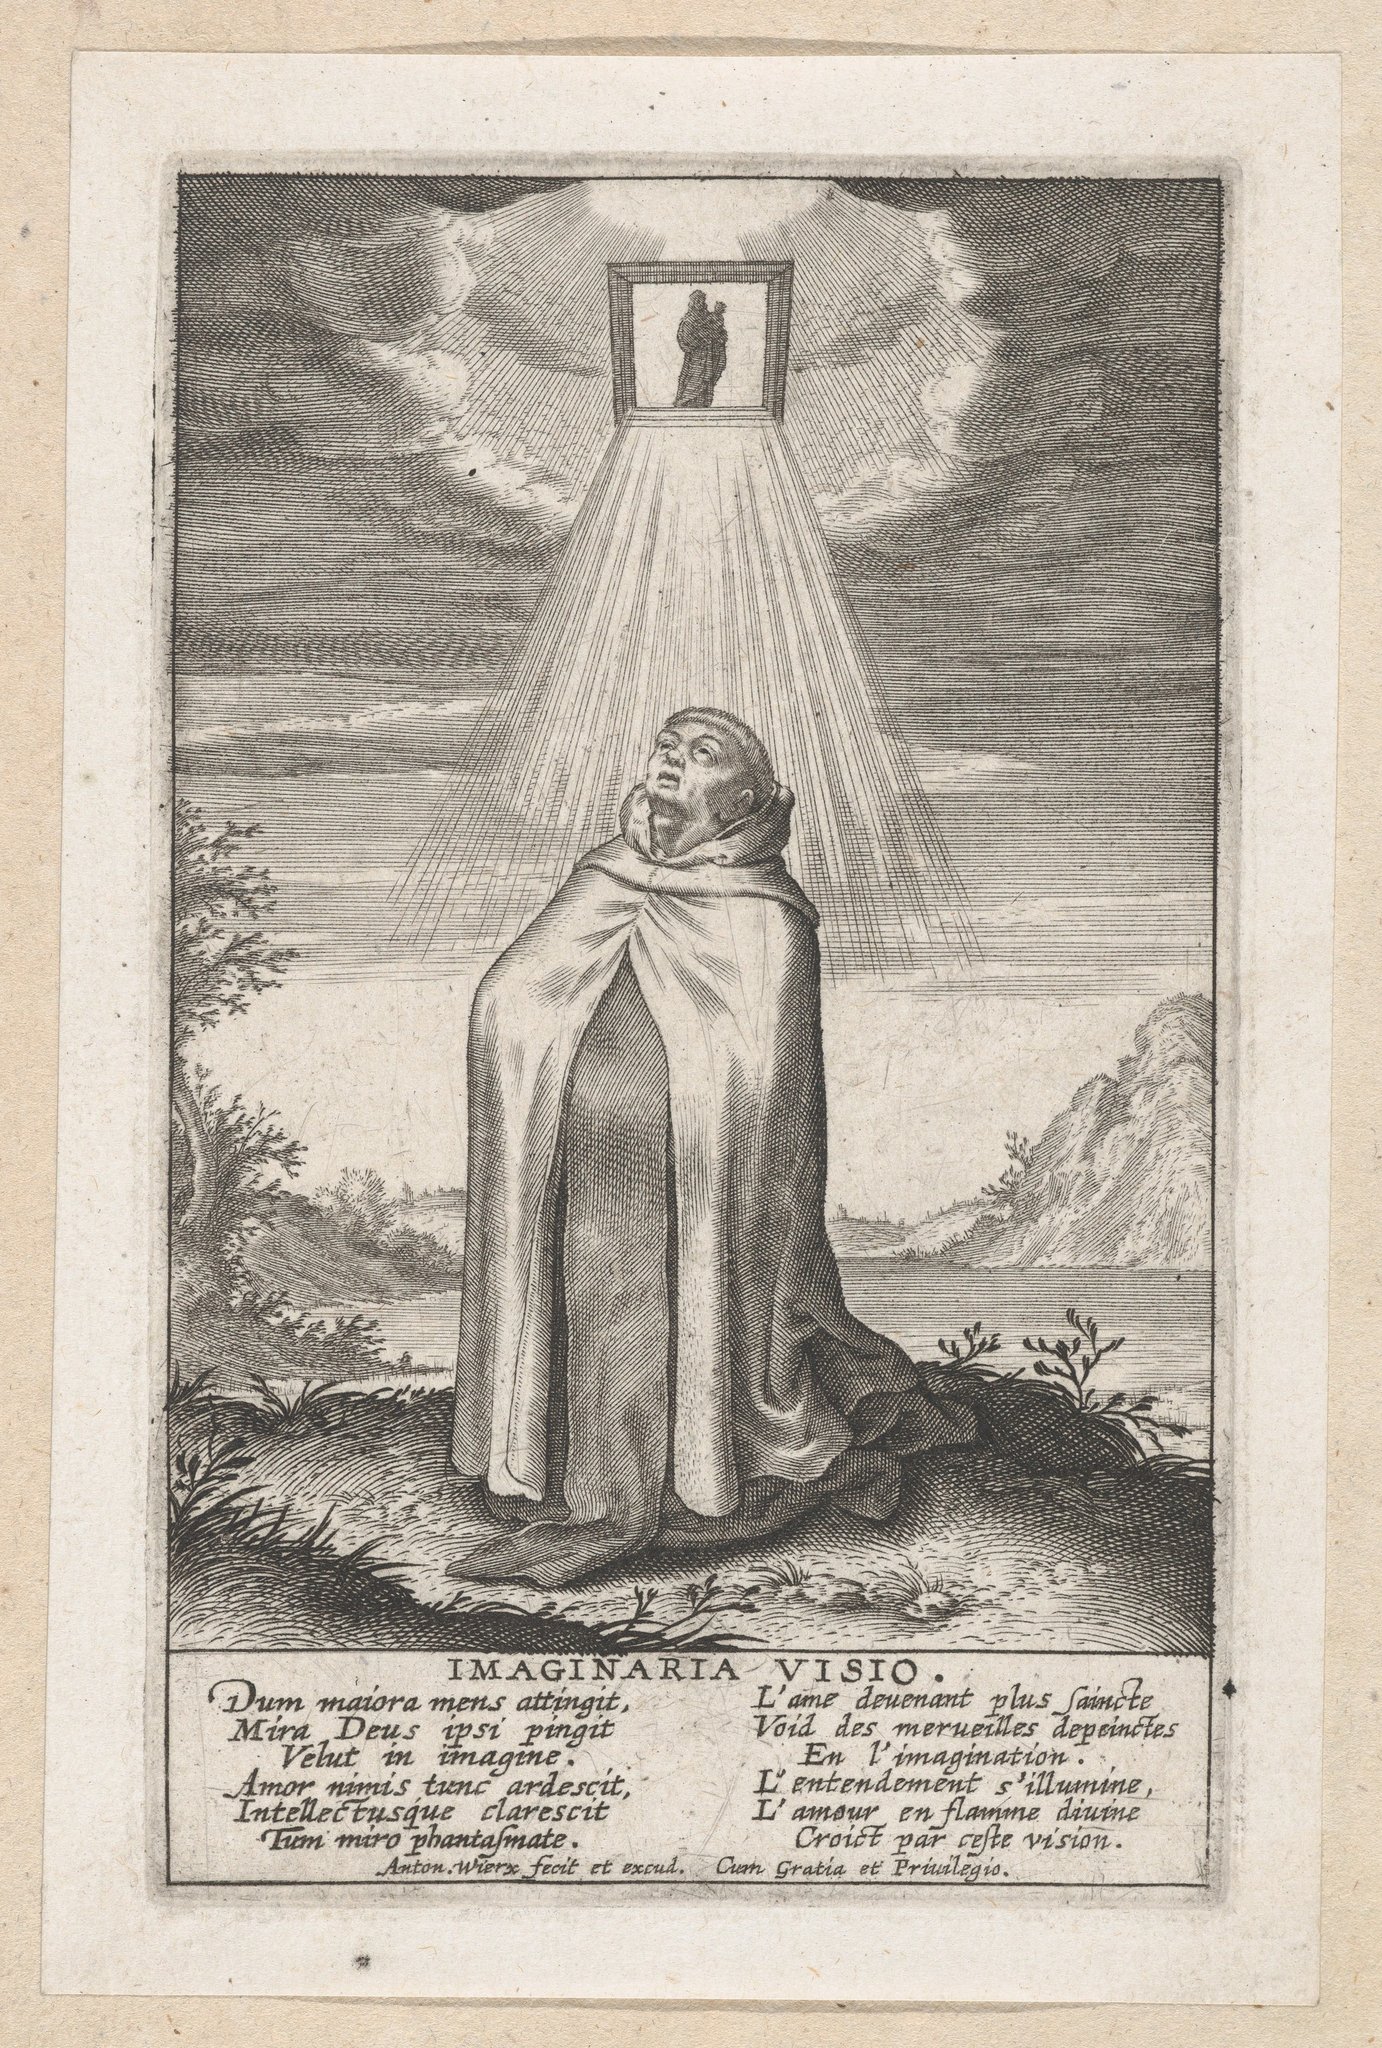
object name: print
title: Imaginaria Visio (La vision de l'imagination)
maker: antonius wierix, ii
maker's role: artist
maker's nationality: netherlandish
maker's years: 1555-1604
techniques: engraving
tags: human figures